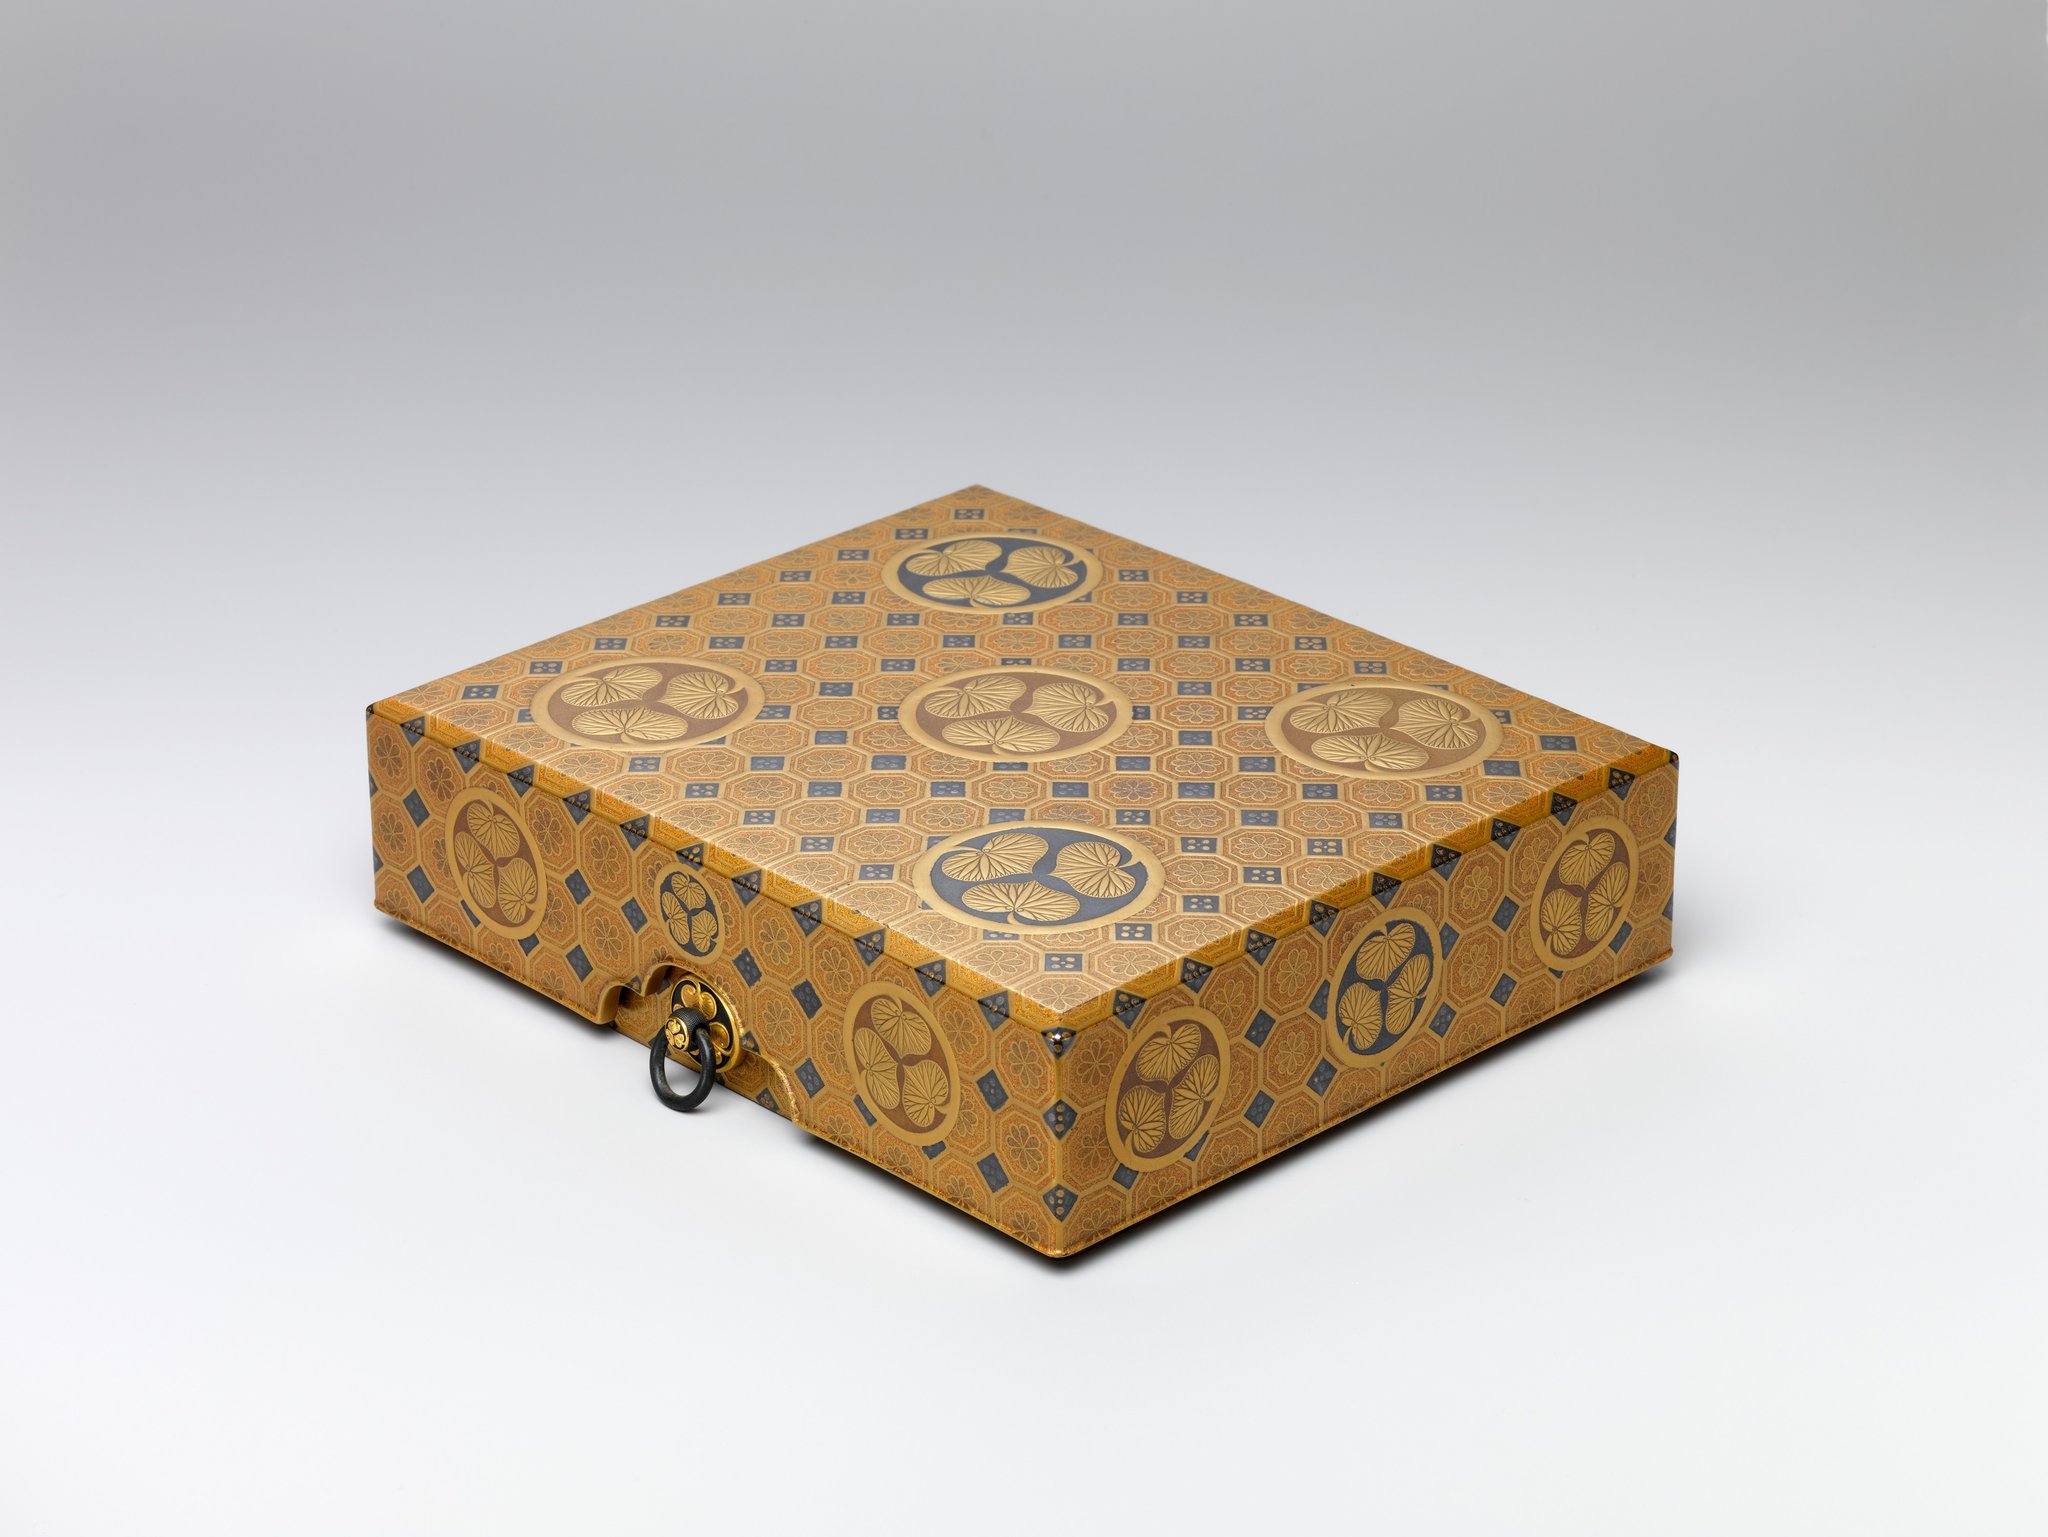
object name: box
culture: japanese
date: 1601-1700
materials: gold, lacquer